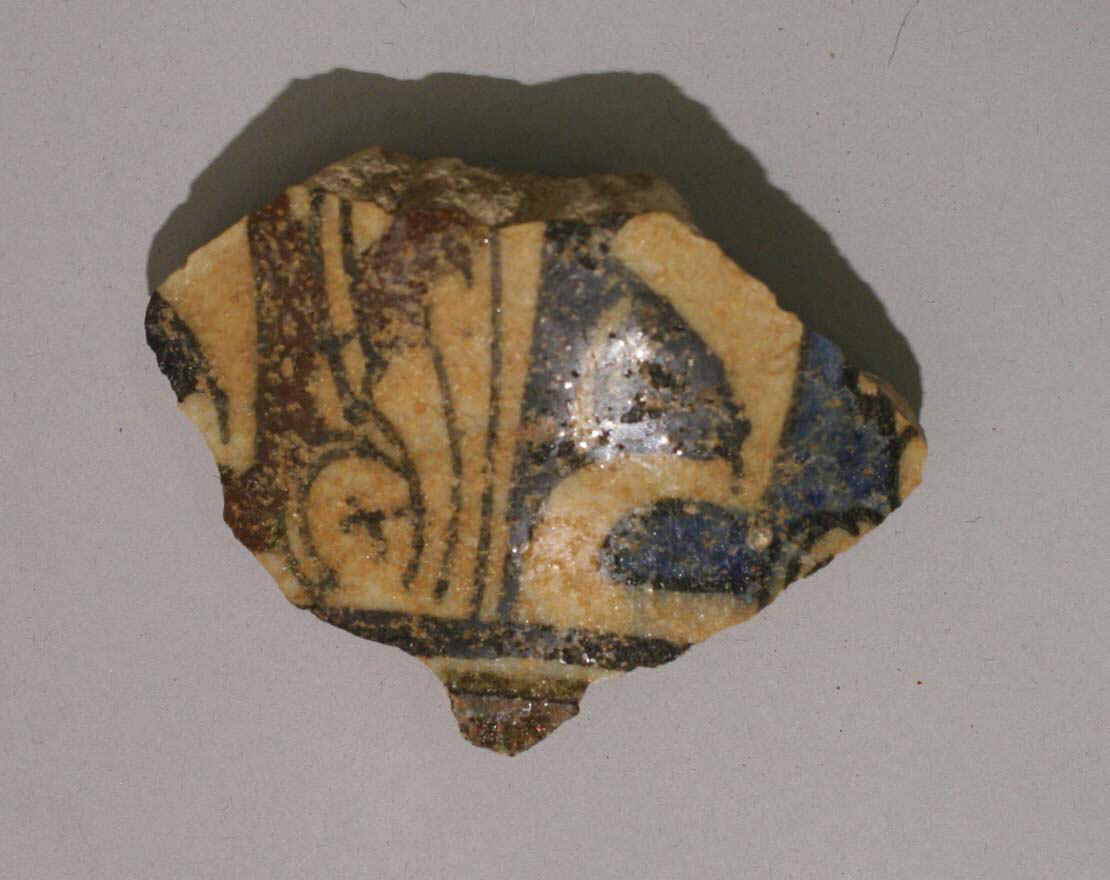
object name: fragment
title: Ceramic Fragment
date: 1201-1300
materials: glaze, stonepaste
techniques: polychrome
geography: syria